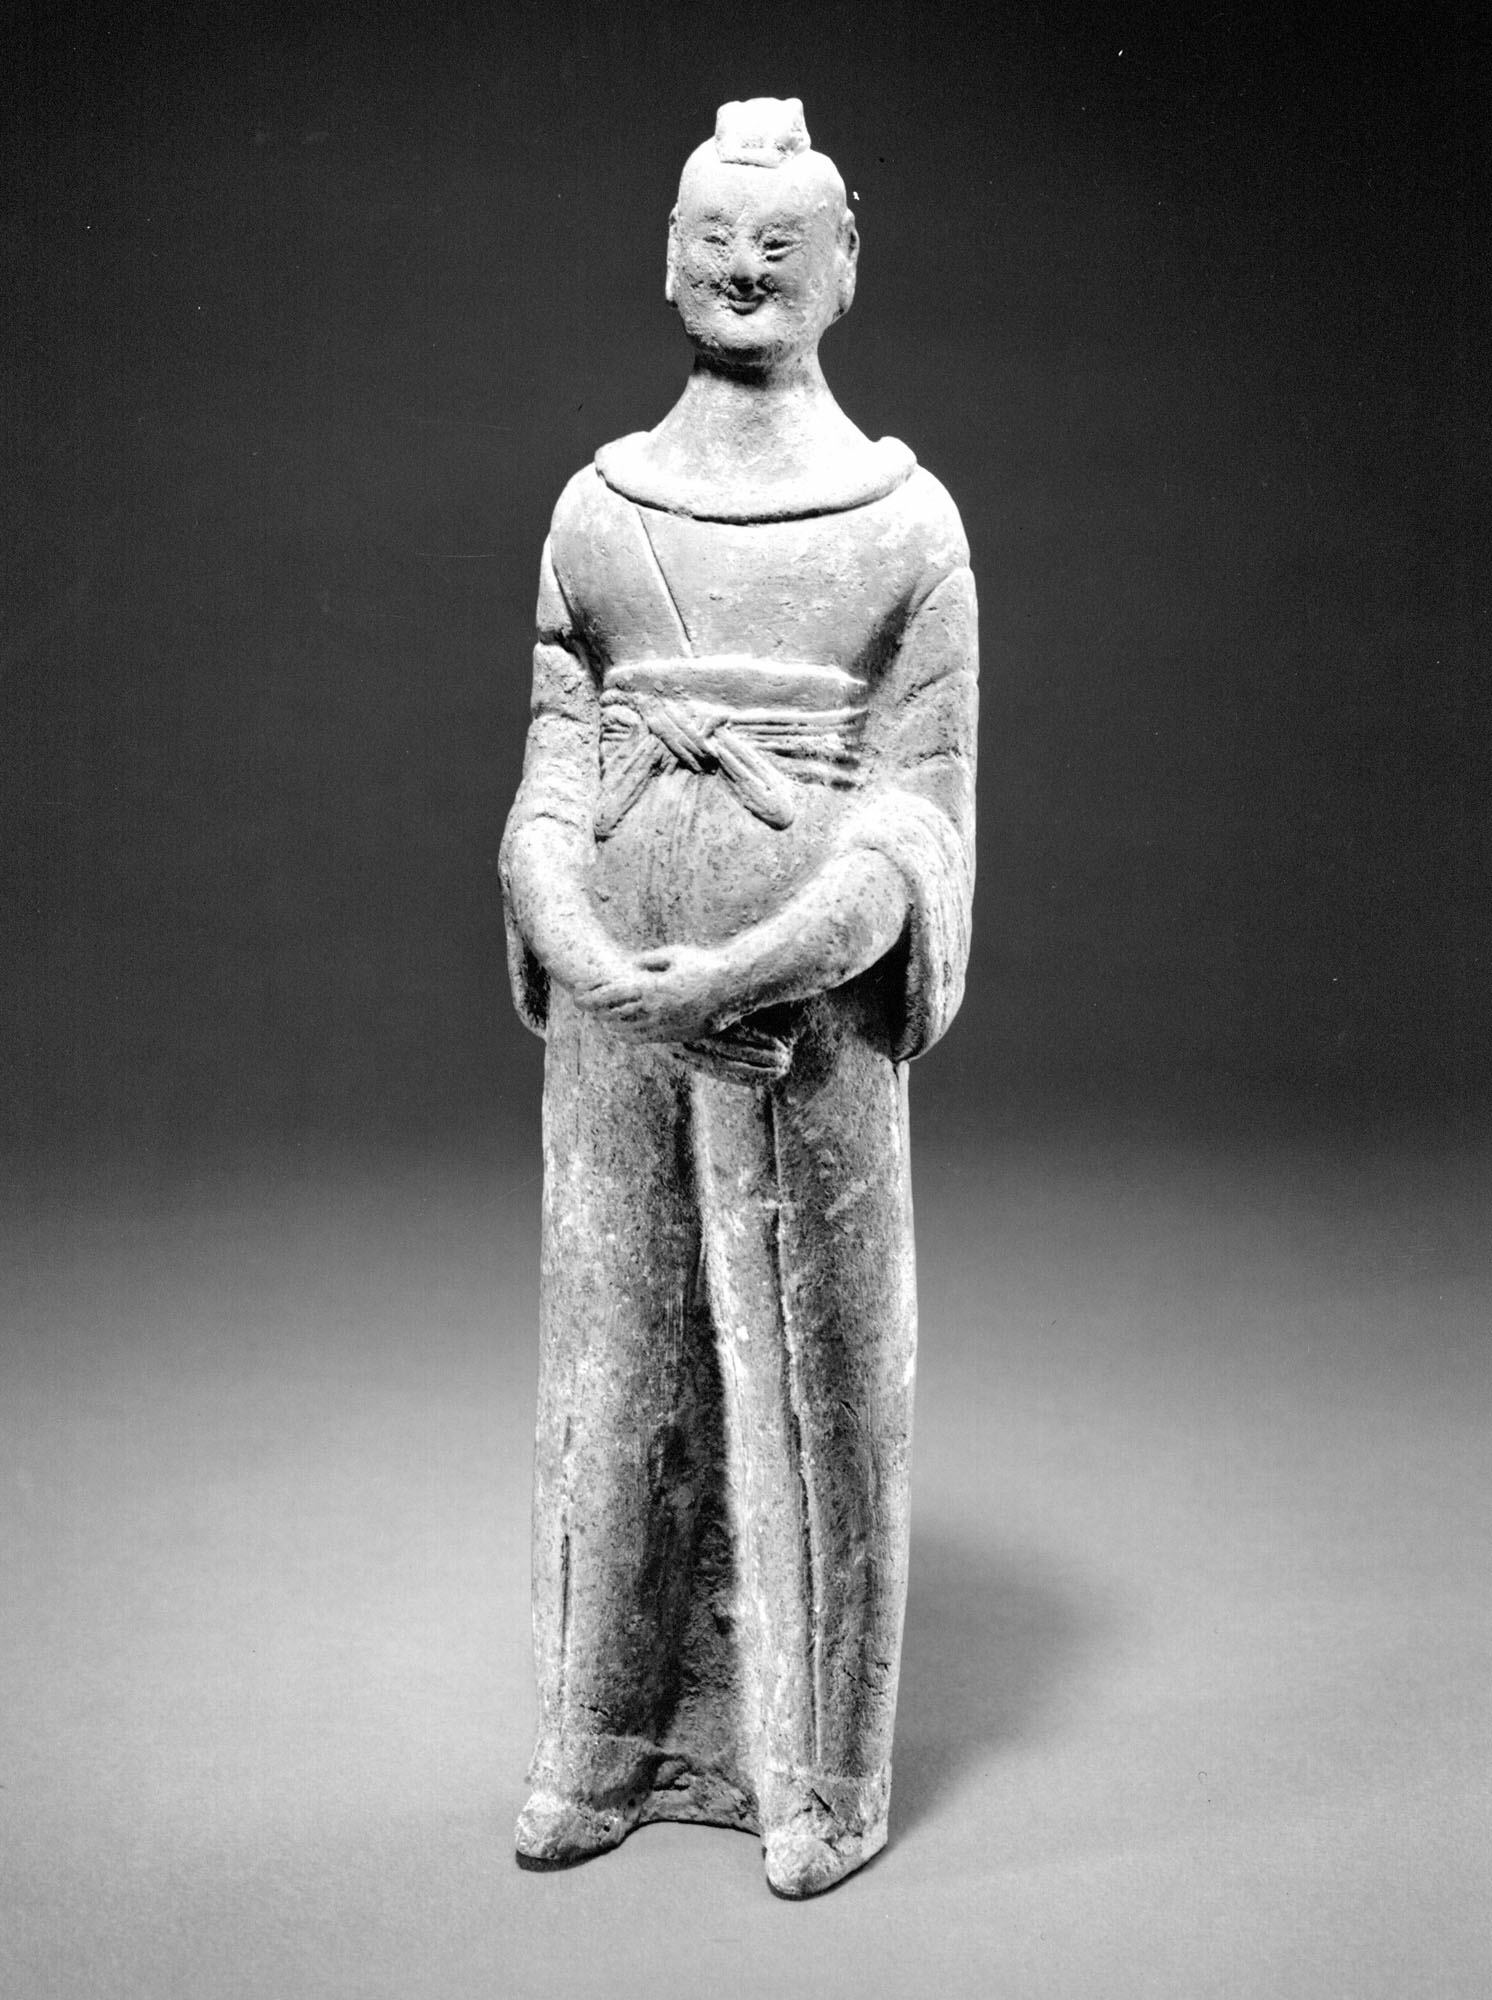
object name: figure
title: Standing Official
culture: chinese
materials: earthenware, pigment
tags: men